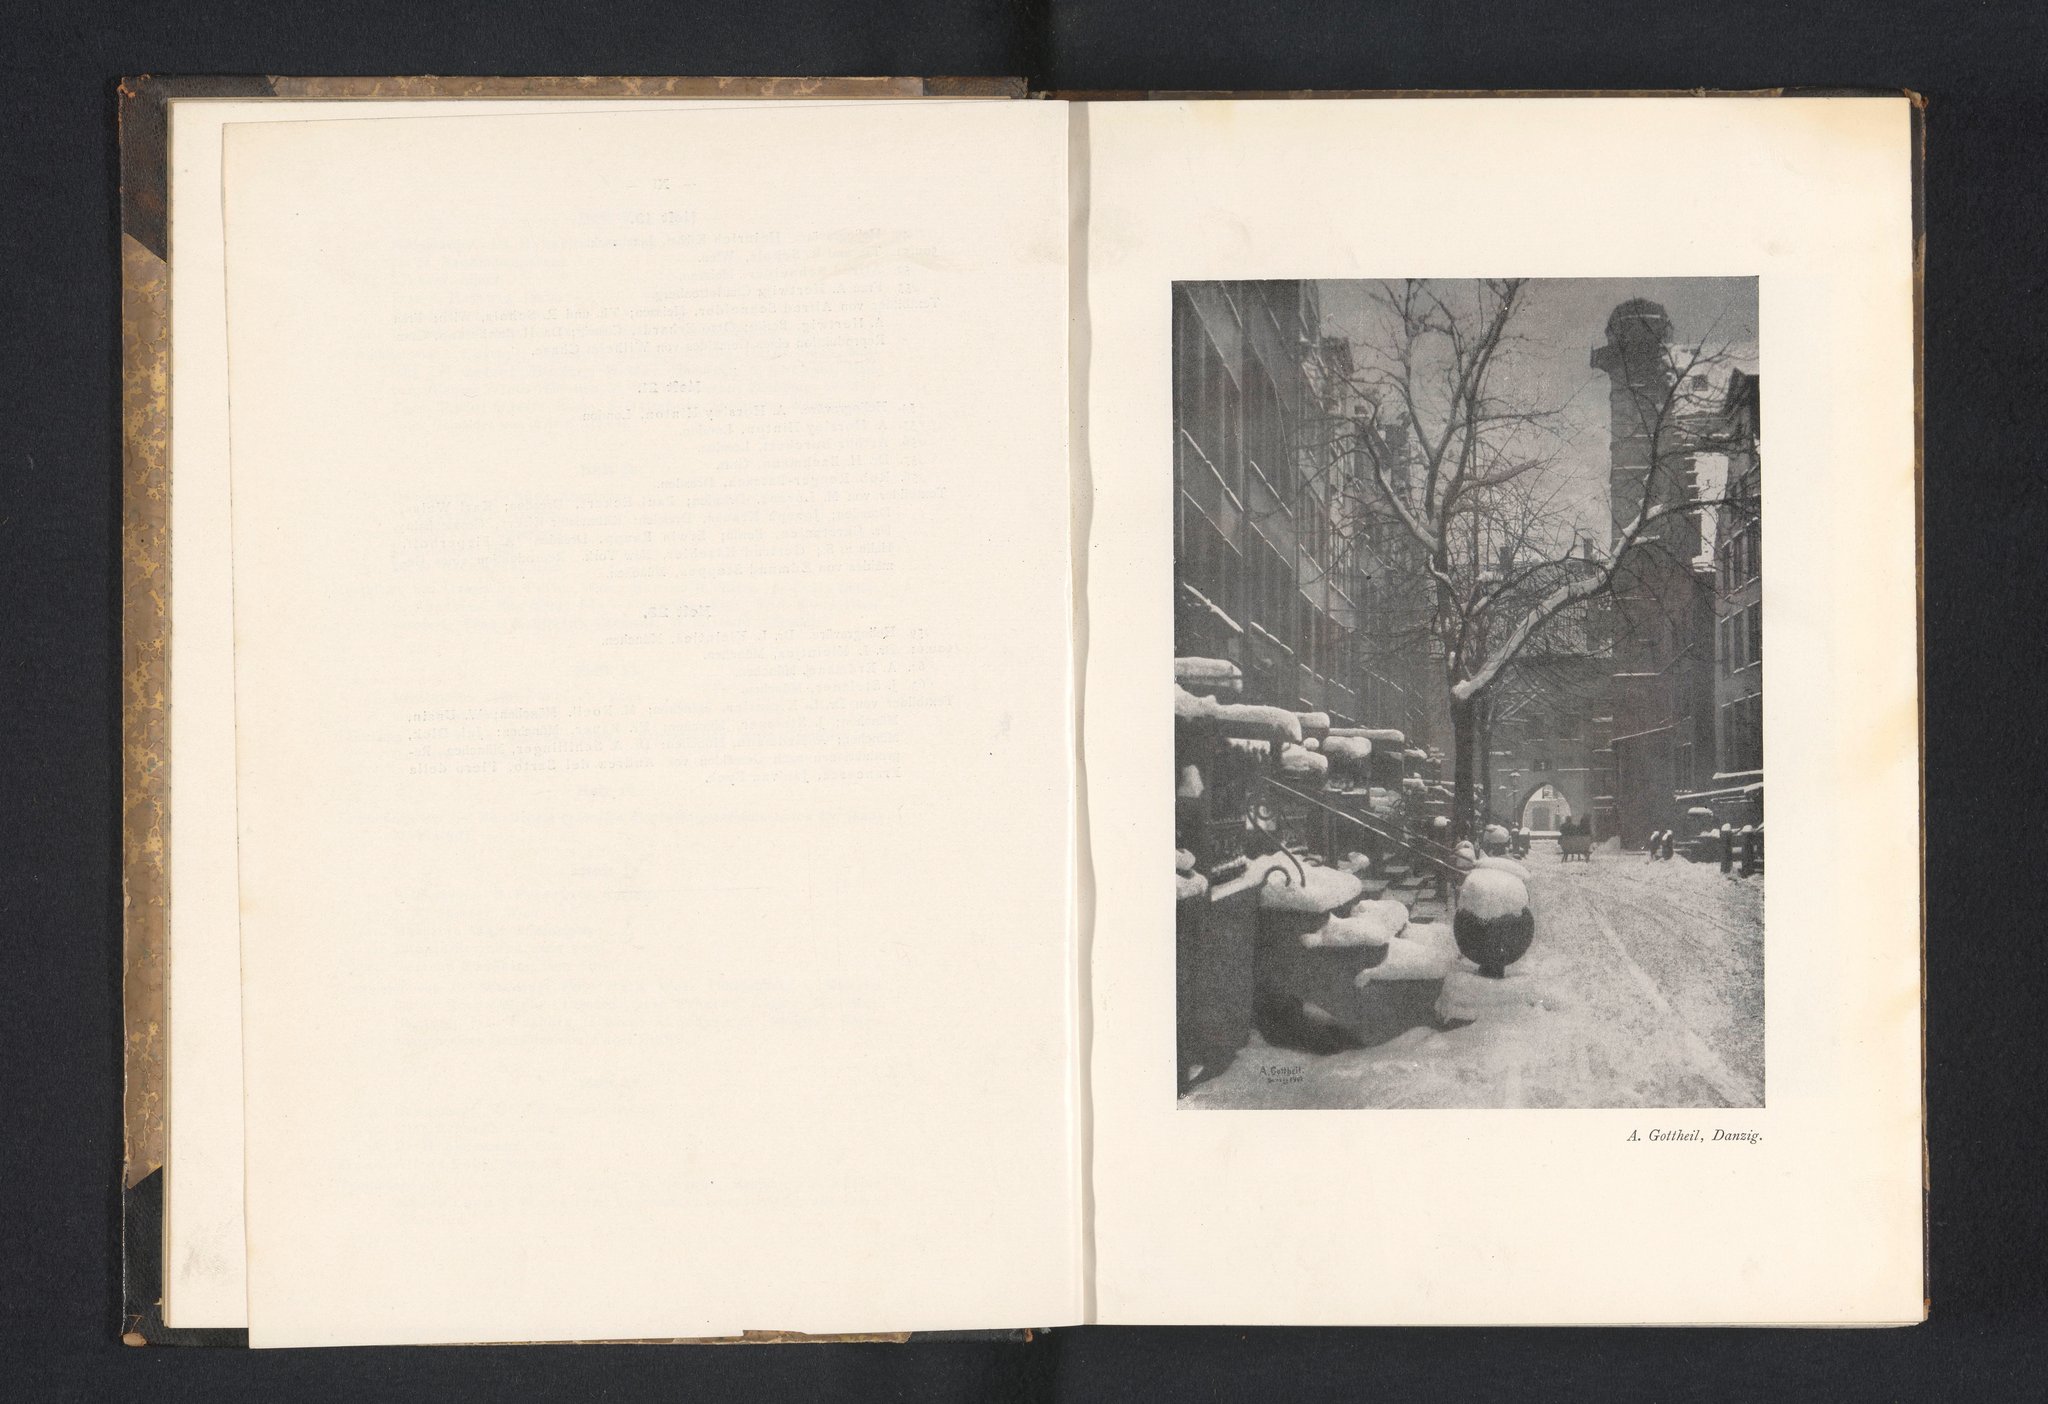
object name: page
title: Gezicht op een straat in de sneeuw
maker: albert gottheil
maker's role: fotograaf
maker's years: 1867-1942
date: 1902-1903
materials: paper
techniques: autotype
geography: berlin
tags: snow, street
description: Prent op eerste ongenummerde pagina na pagina XI.